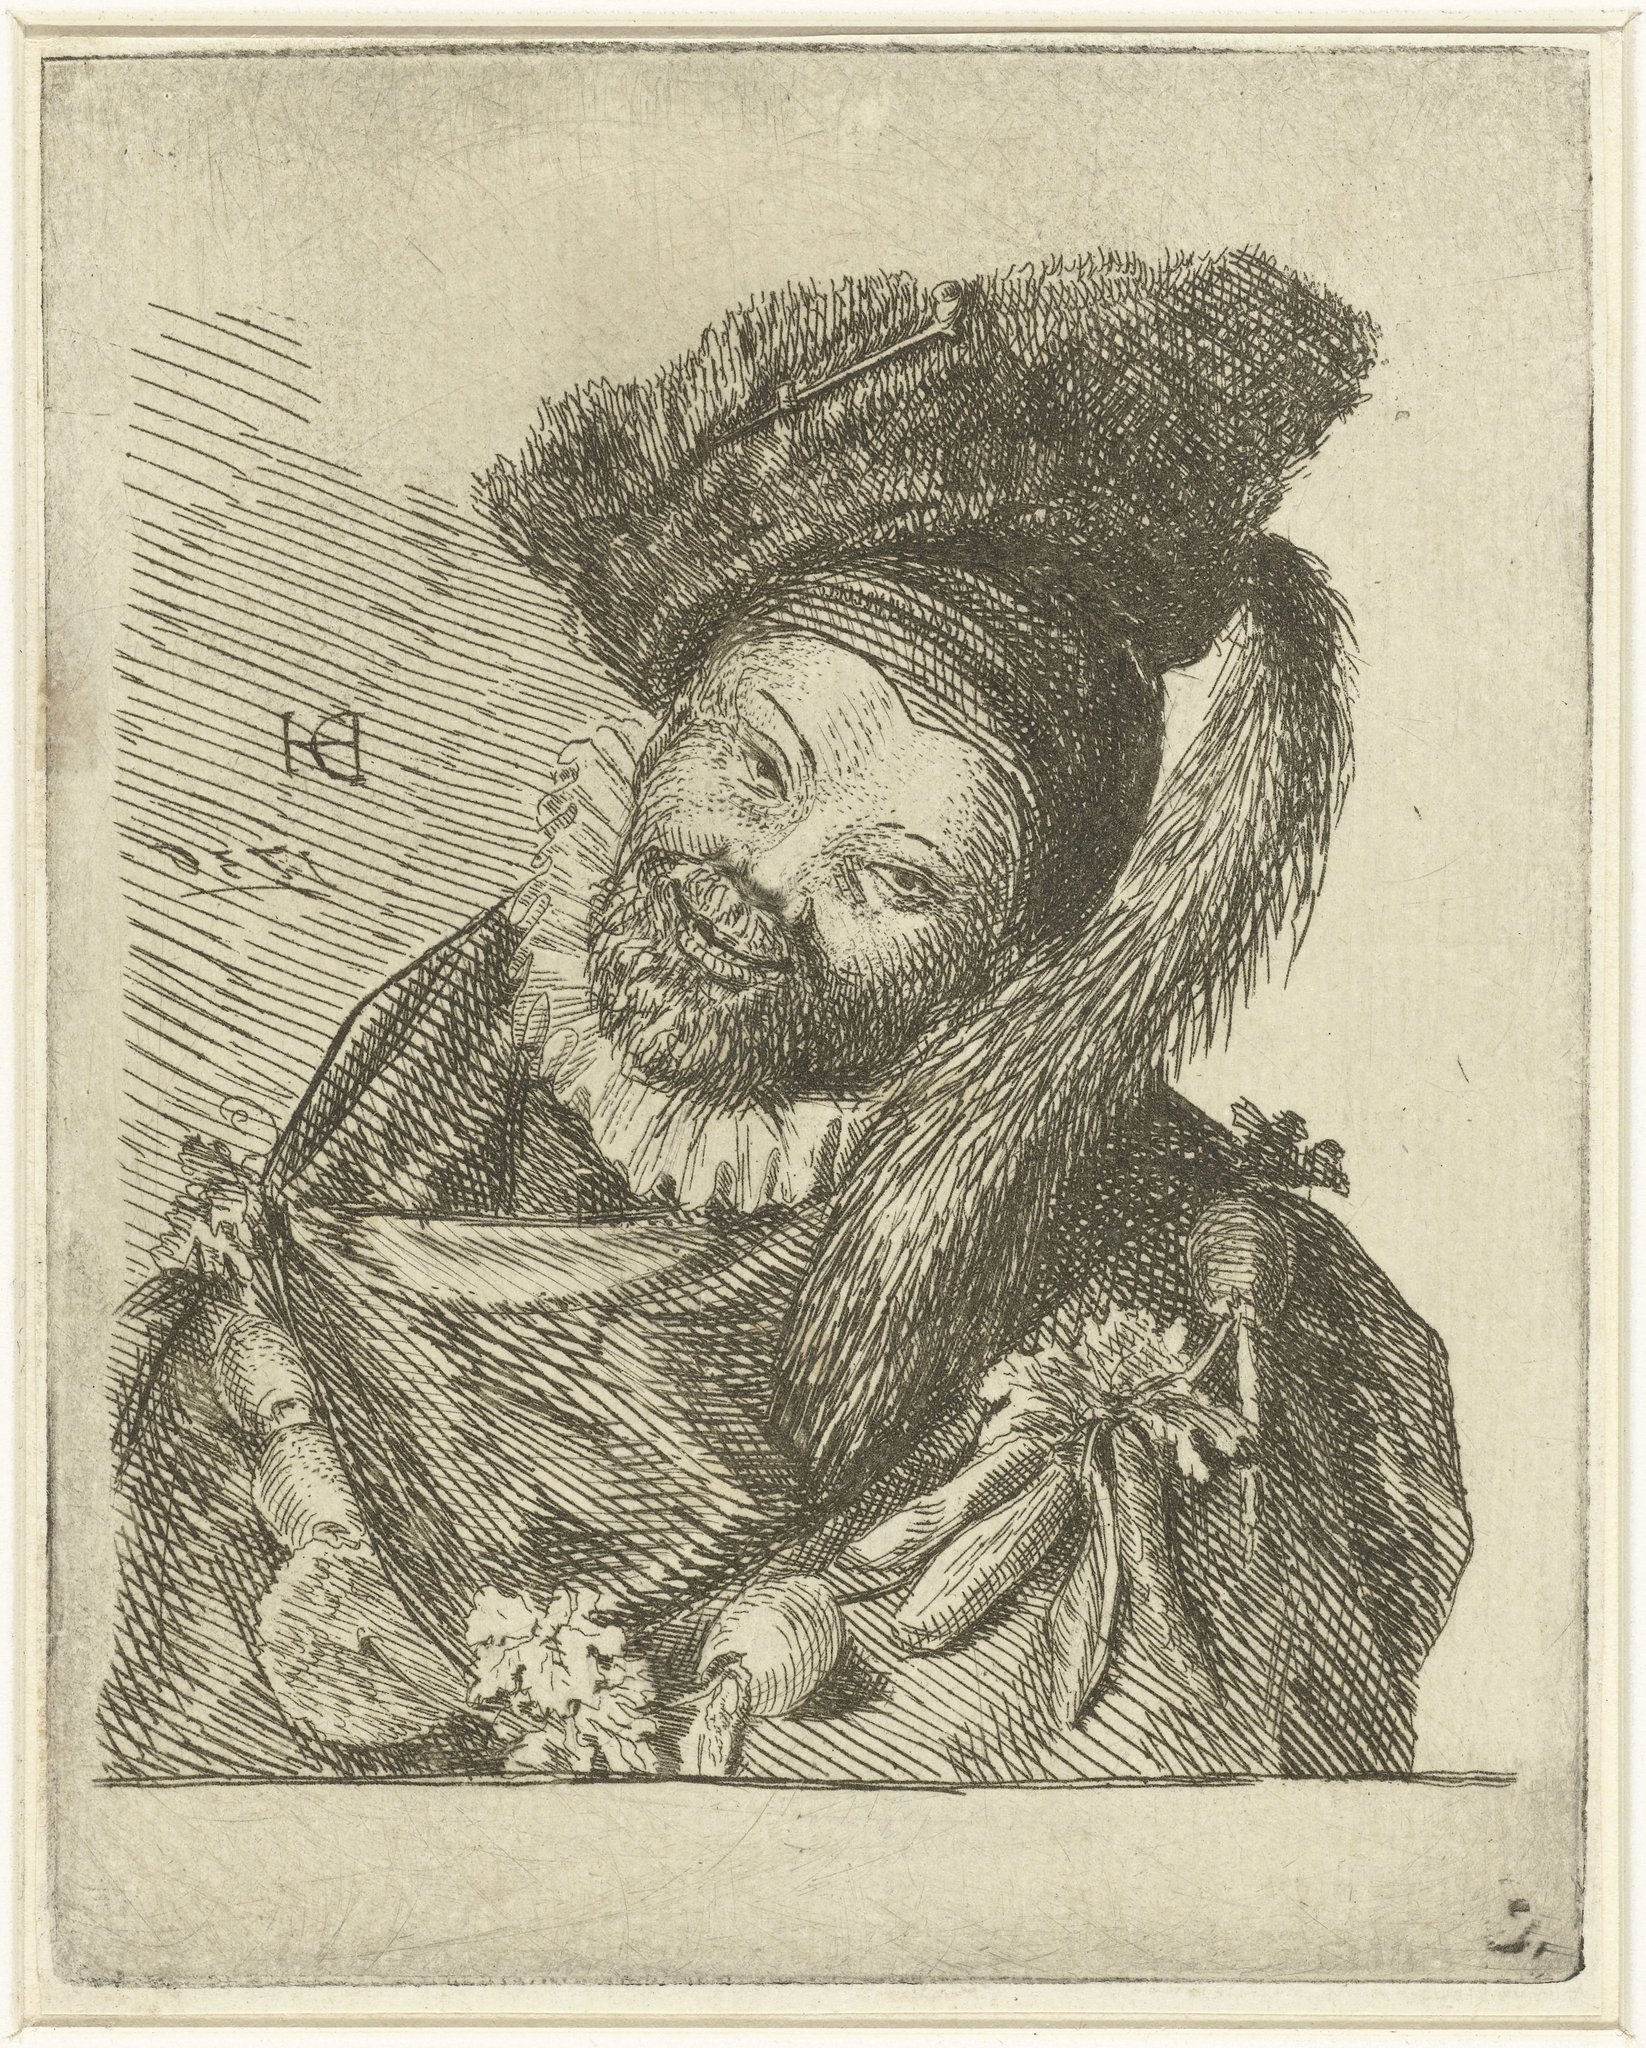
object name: print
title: Nar met groenteketting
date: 1756-1817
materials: paper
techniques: etching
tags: head-gear: cap (+ men's clothes)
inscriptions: collector's mark: Lugt 2228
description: Portretbuste van een lachende nar met een hoed met vossenstaart. Aan de hoed zit in plaats van een hoedenspelt een pijpje. De nar draagt een ketting met verschillende groentes en bloemen.